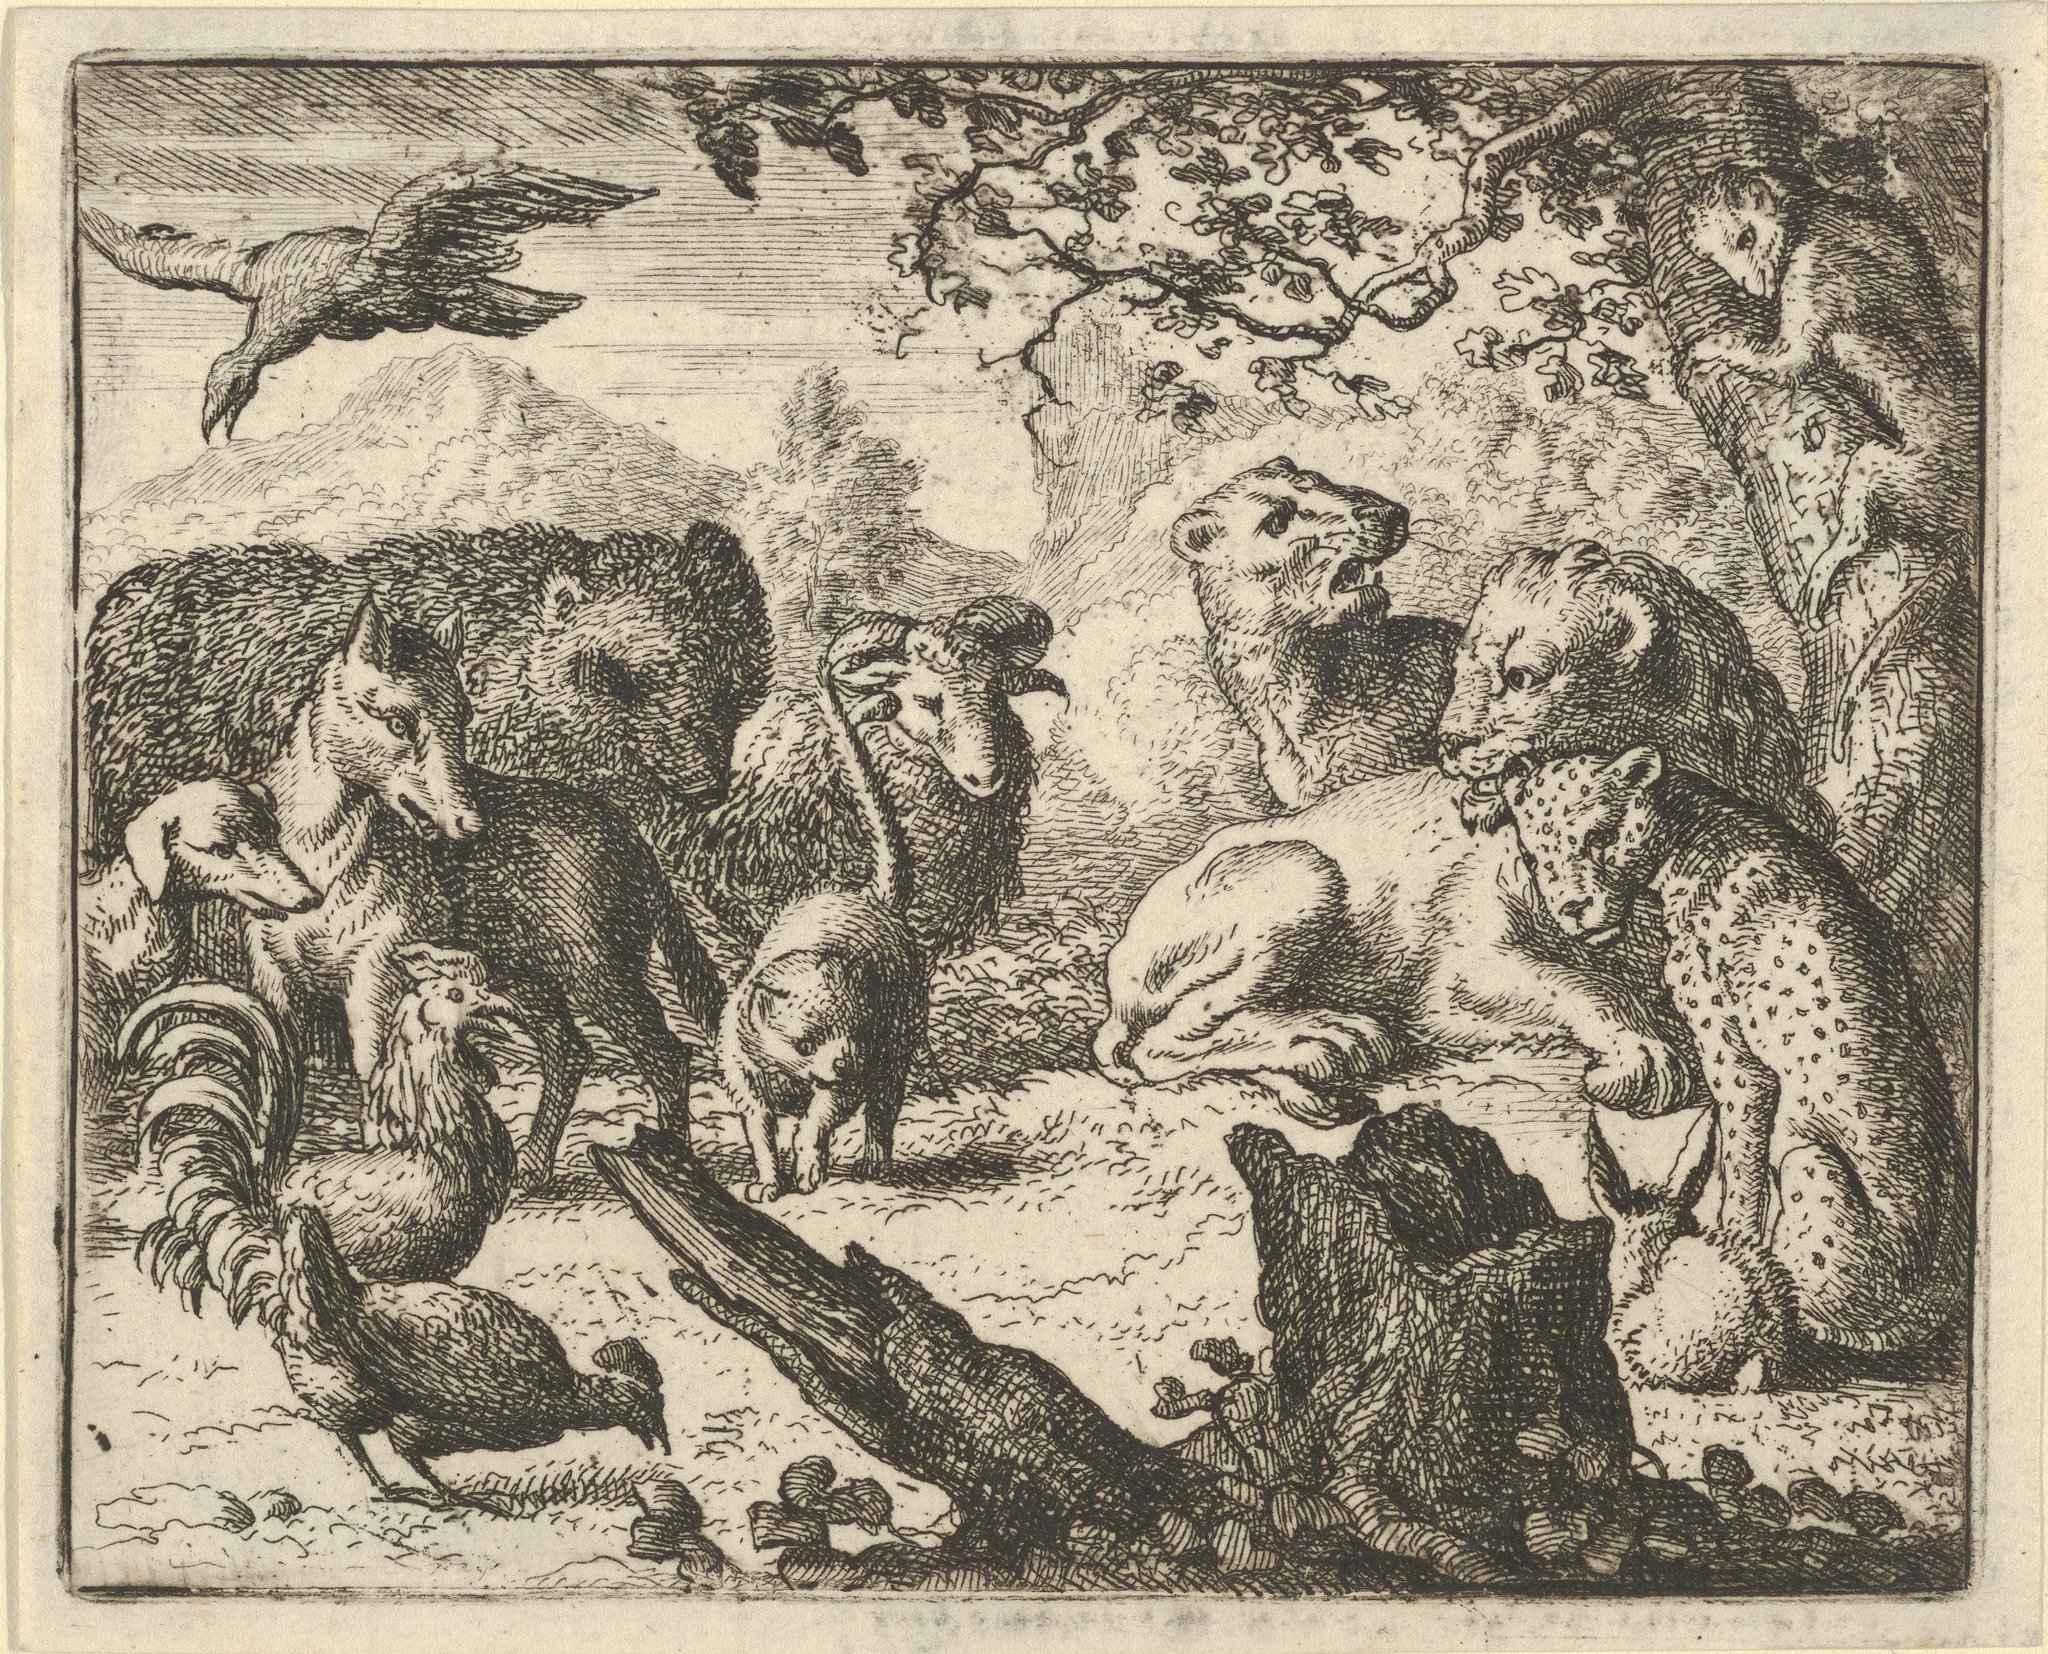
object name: print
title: The Lion Announces a Durable Peace to the Animals who Surround Him from Hendrick van Alcmar's Renard The Fox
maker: allart van everdingen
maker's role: artist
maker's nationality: dutch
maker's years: 1621-1675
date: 1650-1675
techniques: engraving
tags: bears,birds,chickens,cheetahs,lions,monkeys